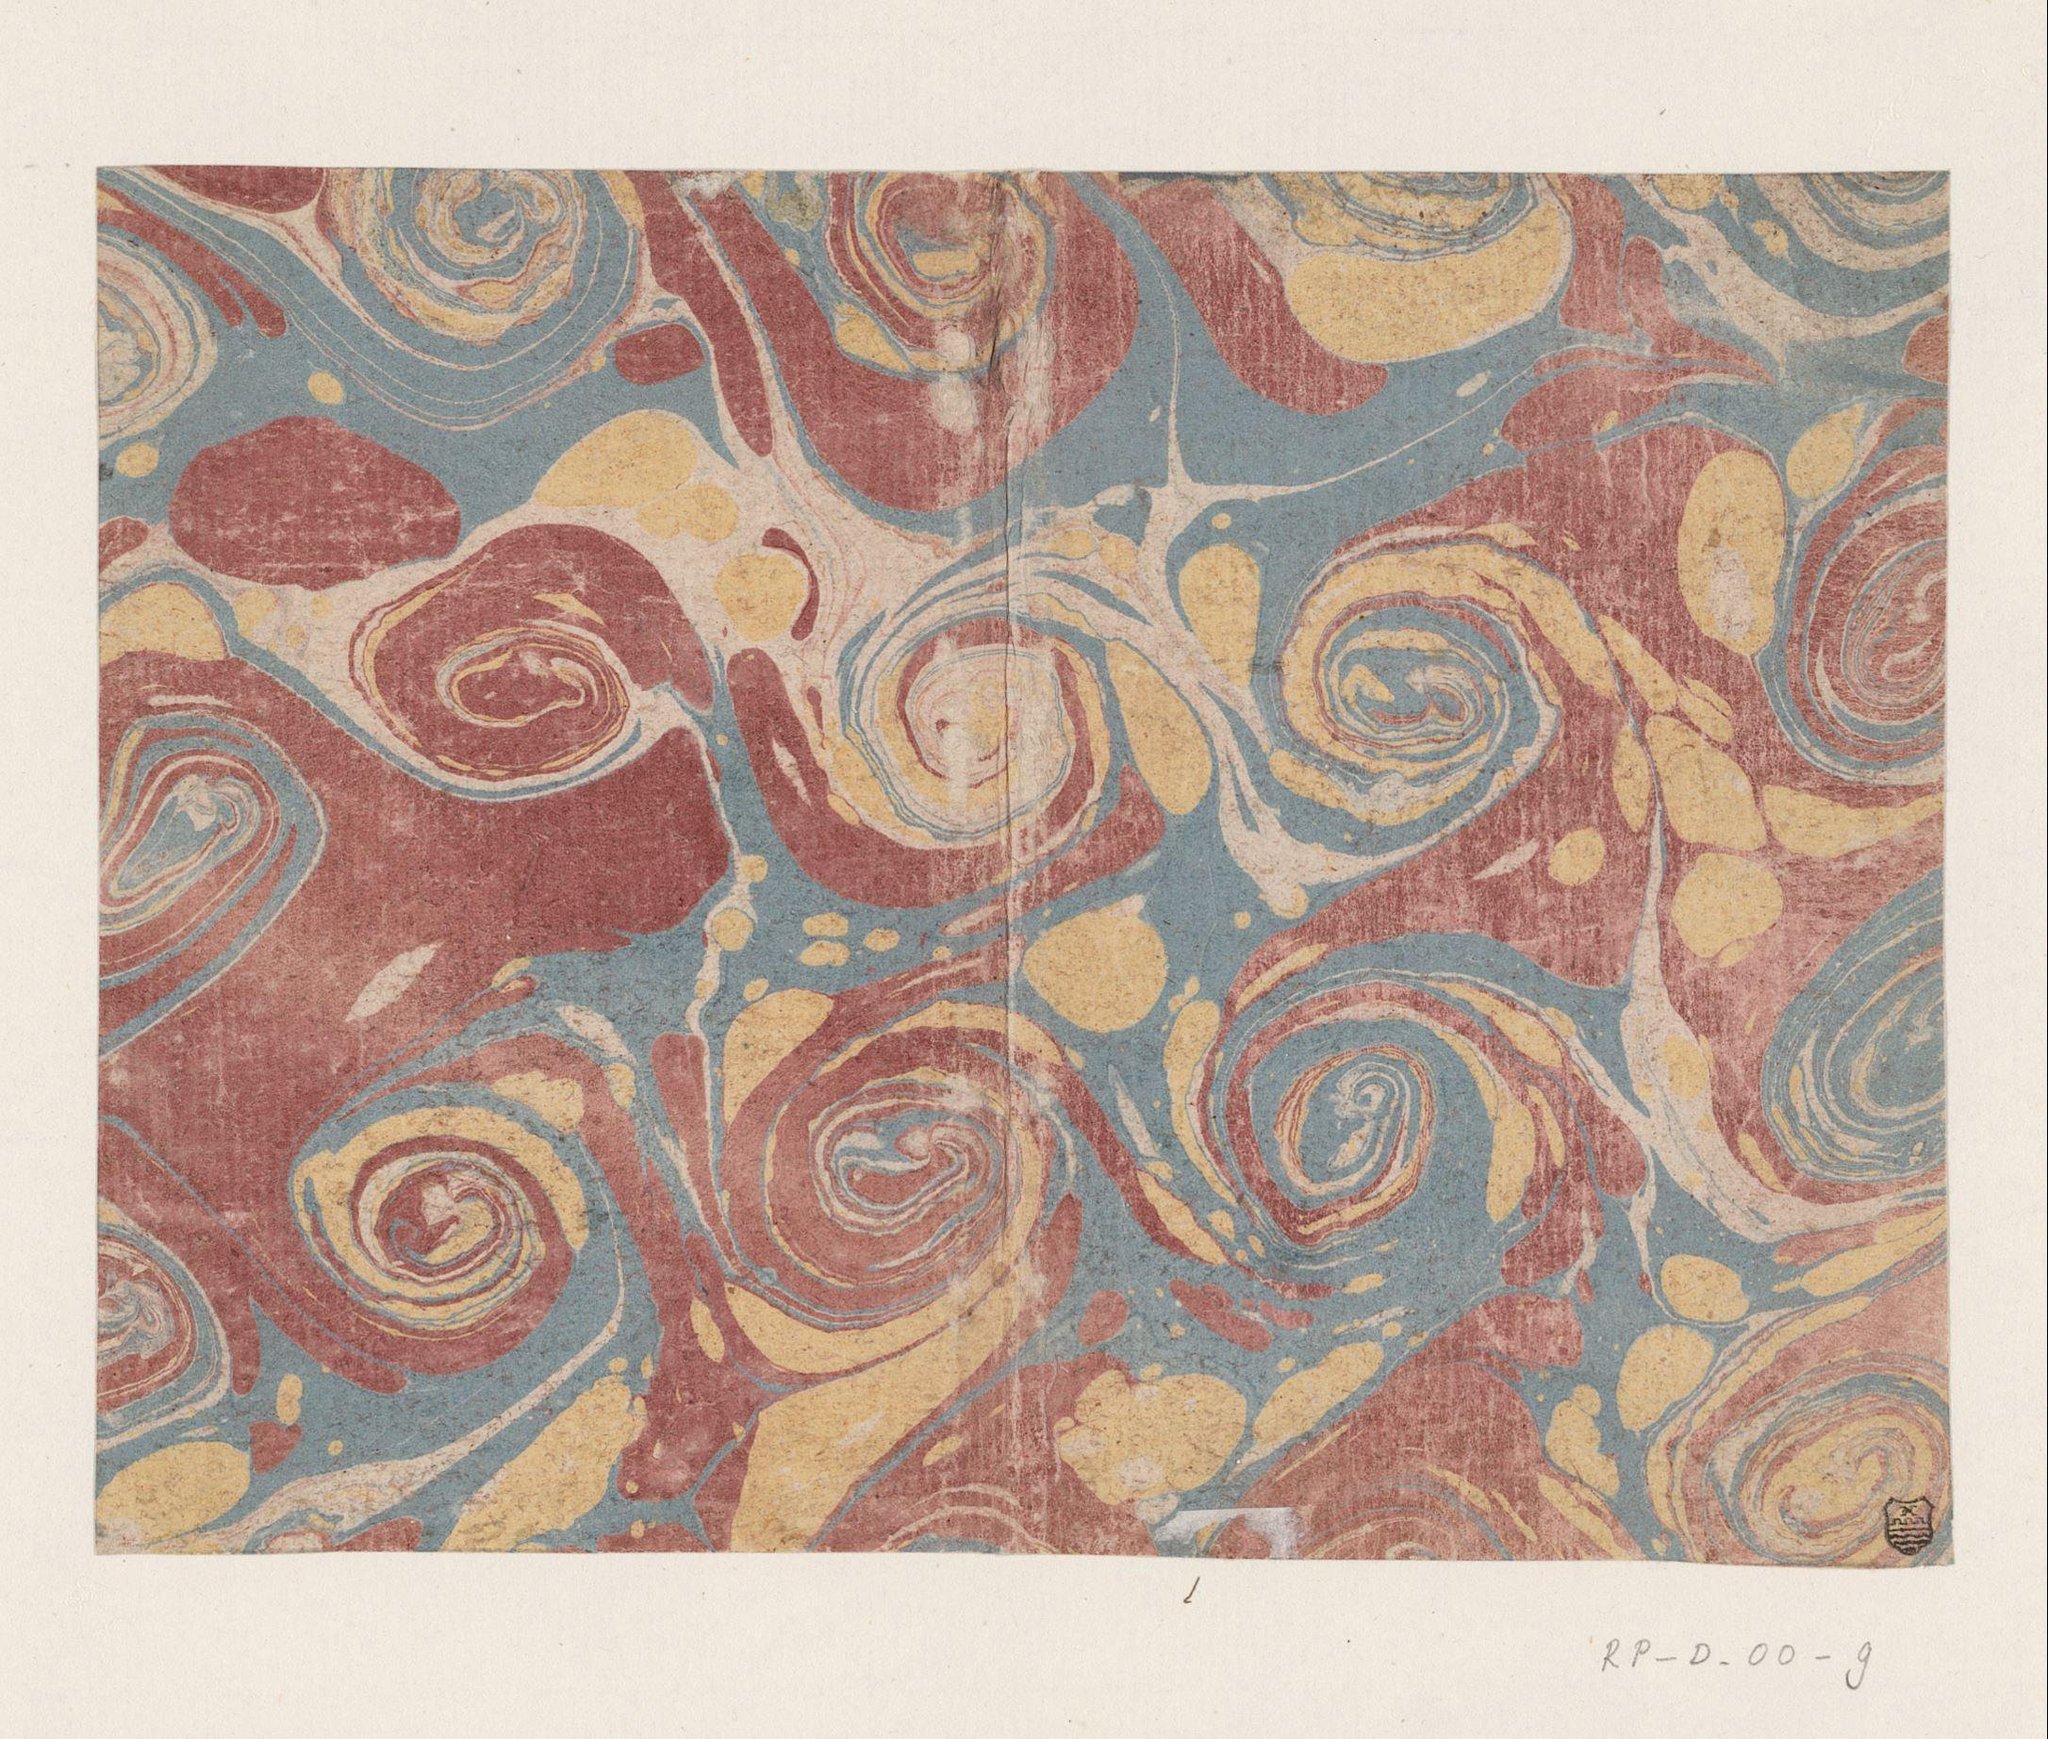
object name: wrapper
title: Spiraalmarmer in blauw, rood en geel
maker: Anonymous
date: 1700-1800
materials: paint, paper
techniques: marbled paper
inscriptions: collector's mark: Lugt 2760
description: Spiraalmarmer in blauw, rood en geel. Gebruikt als omslag.